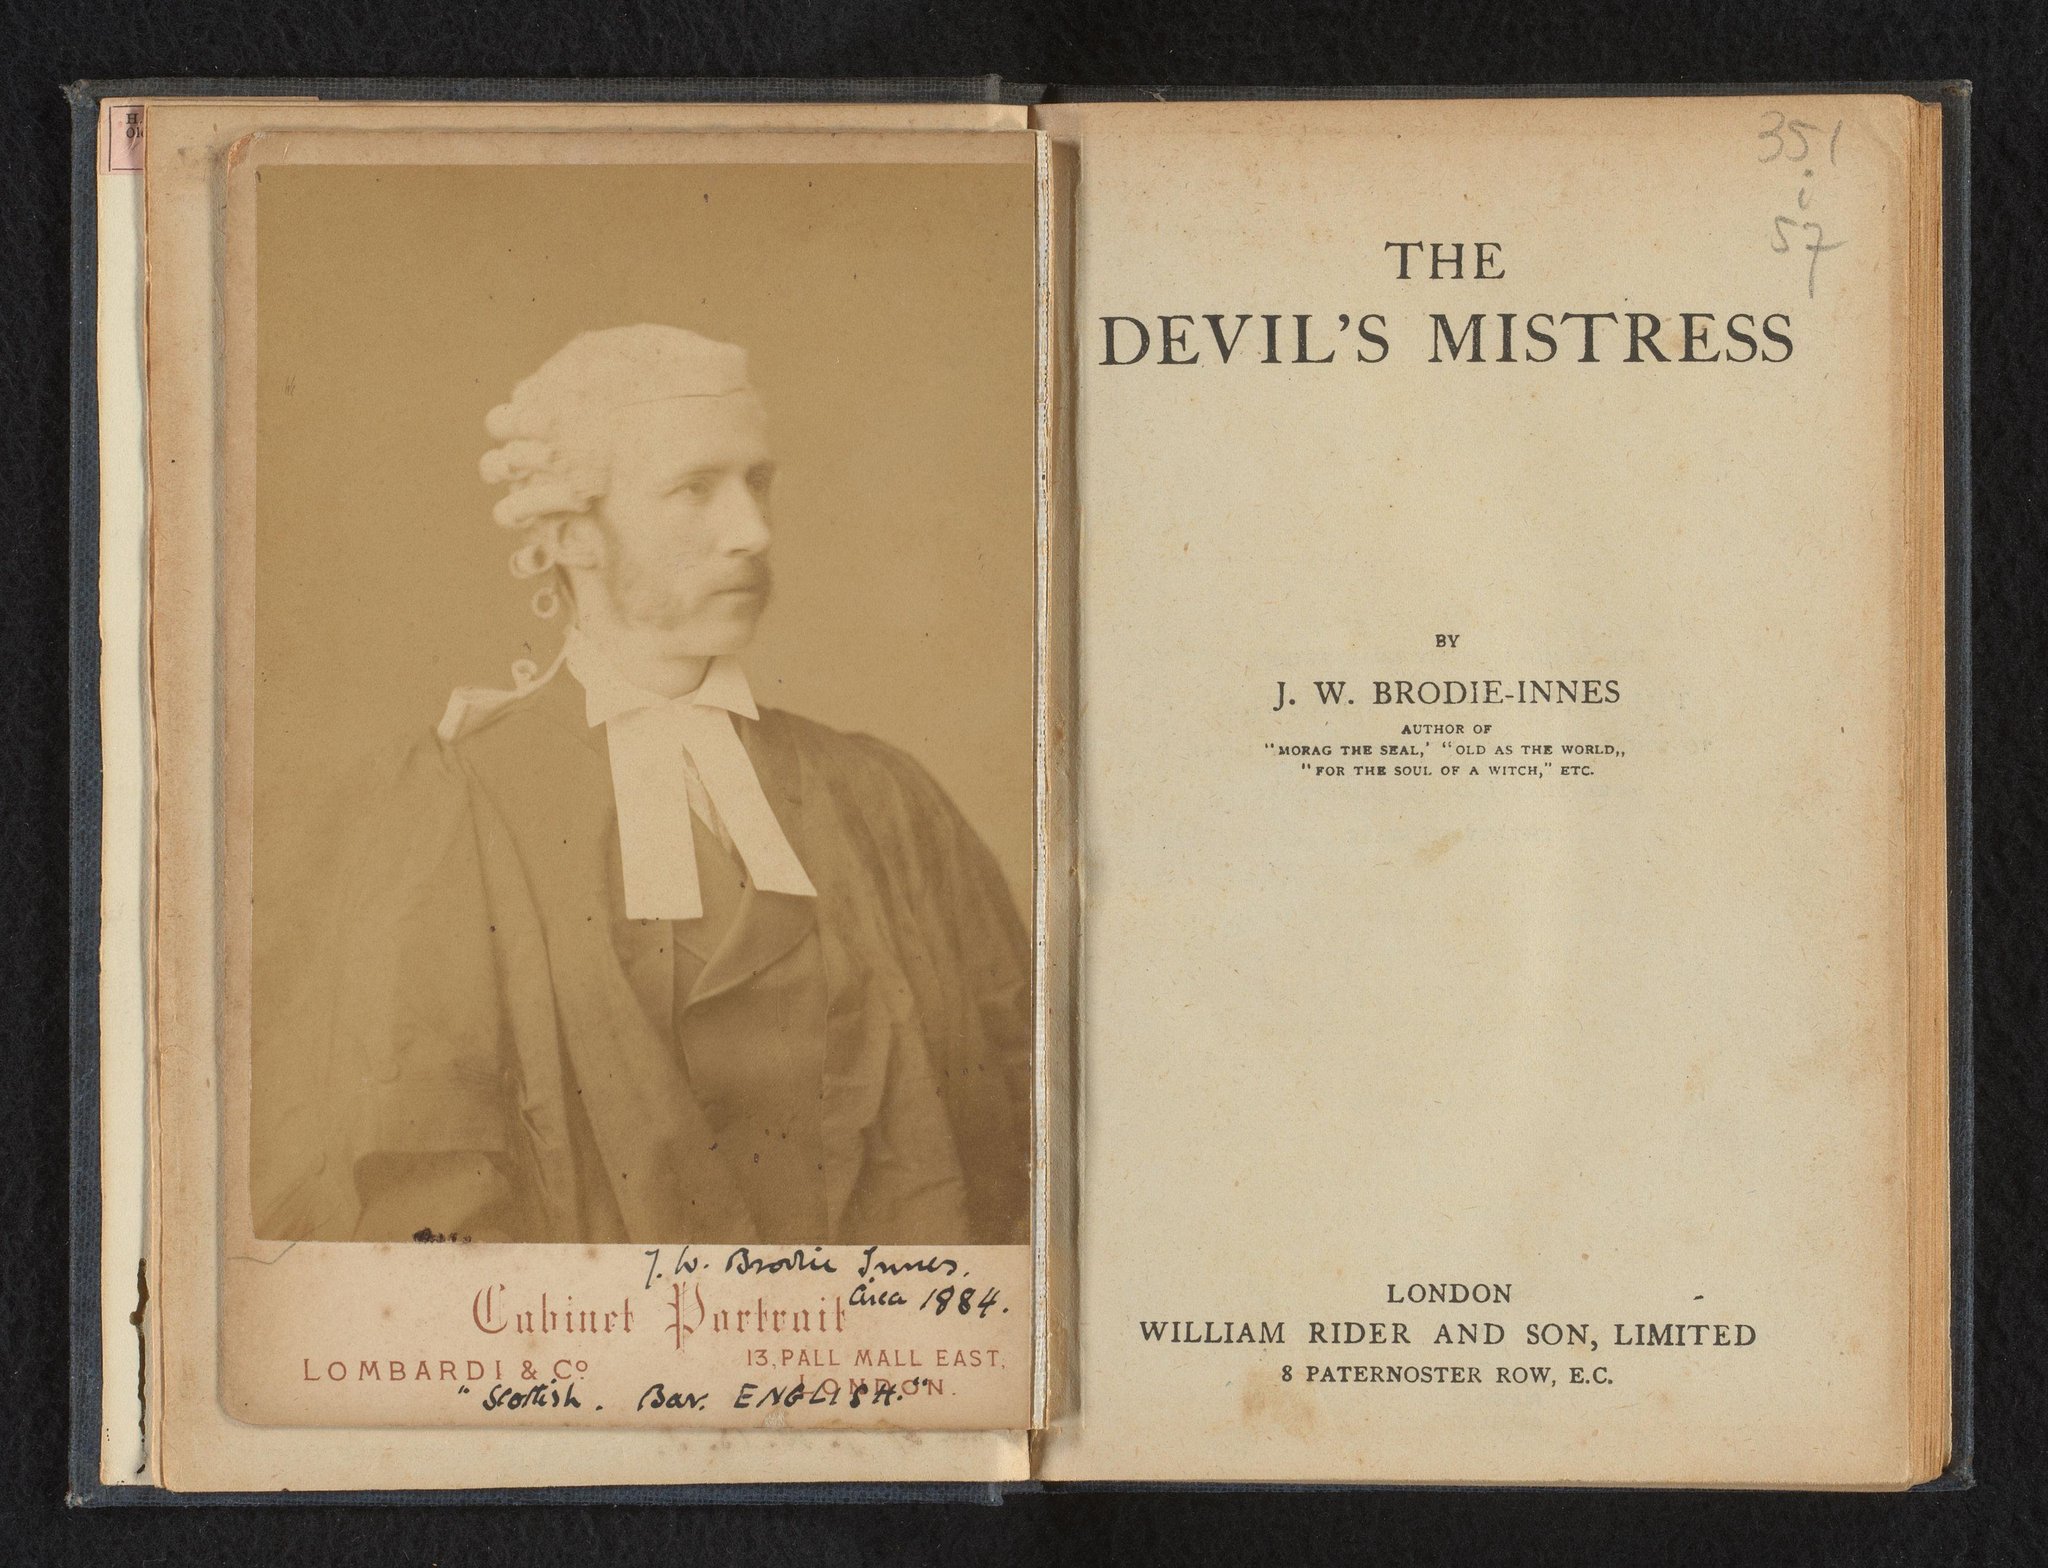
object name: page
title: Portret van J.W. Brodie-Innes, in toga met pruik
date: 1884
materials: cardboard, paper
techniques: albumen print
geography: london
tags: john william brodie-innes, historical persons, portrait of a writer, wig, dress, gown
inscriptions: inscription: ‘J.W. Brodie-Innes./ Circa 1884./ Scottish. Bar. ENGLISH.’, inscription: ‘Cabinet Portrait/ Lombardi & Co./ 13, Pall Mall East./ London.’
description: Foto in boek geplakt als ware het een pagina, tegenover de titelpagina.